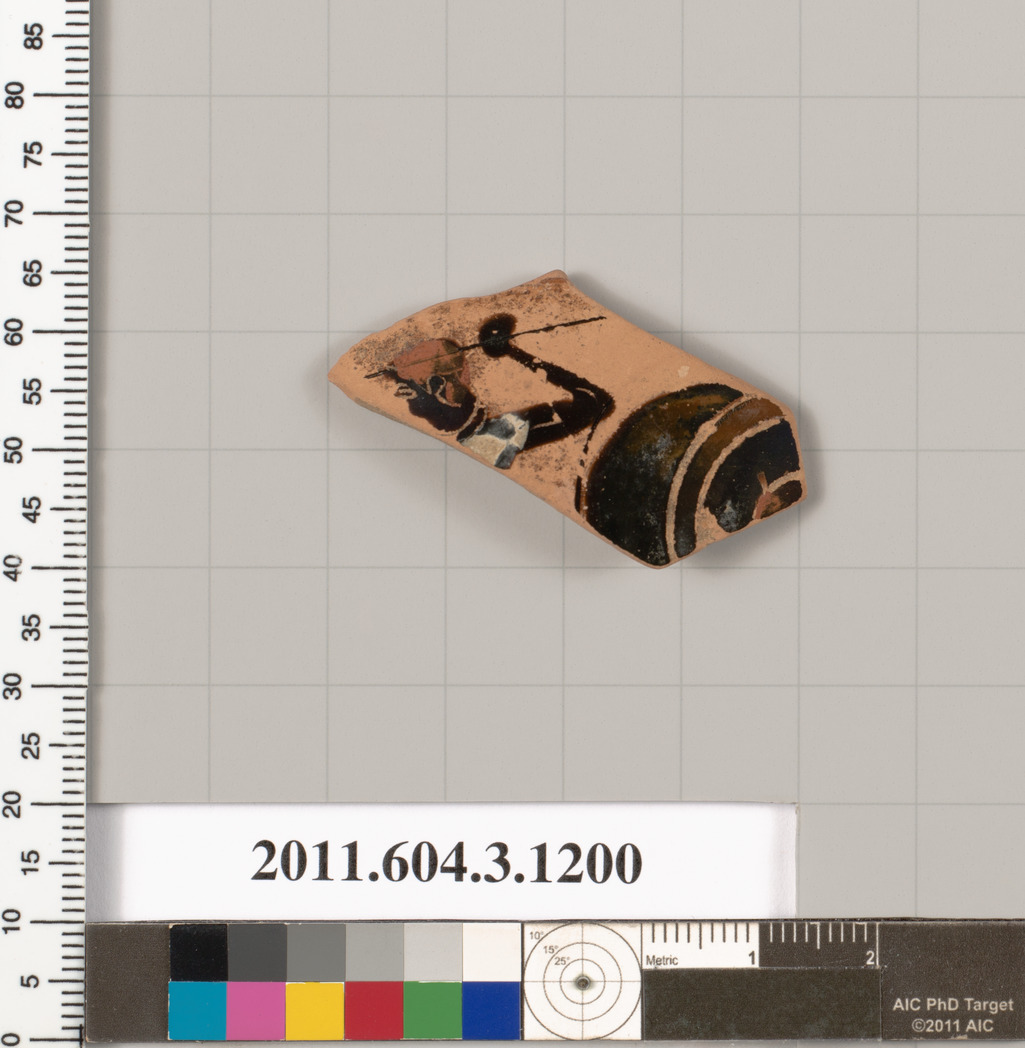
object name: mastoid fragment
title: Terracotta fragment of a mastoid (drinking cup with narrow base)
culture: greek, attic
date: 534-468 BCE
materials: terracotta